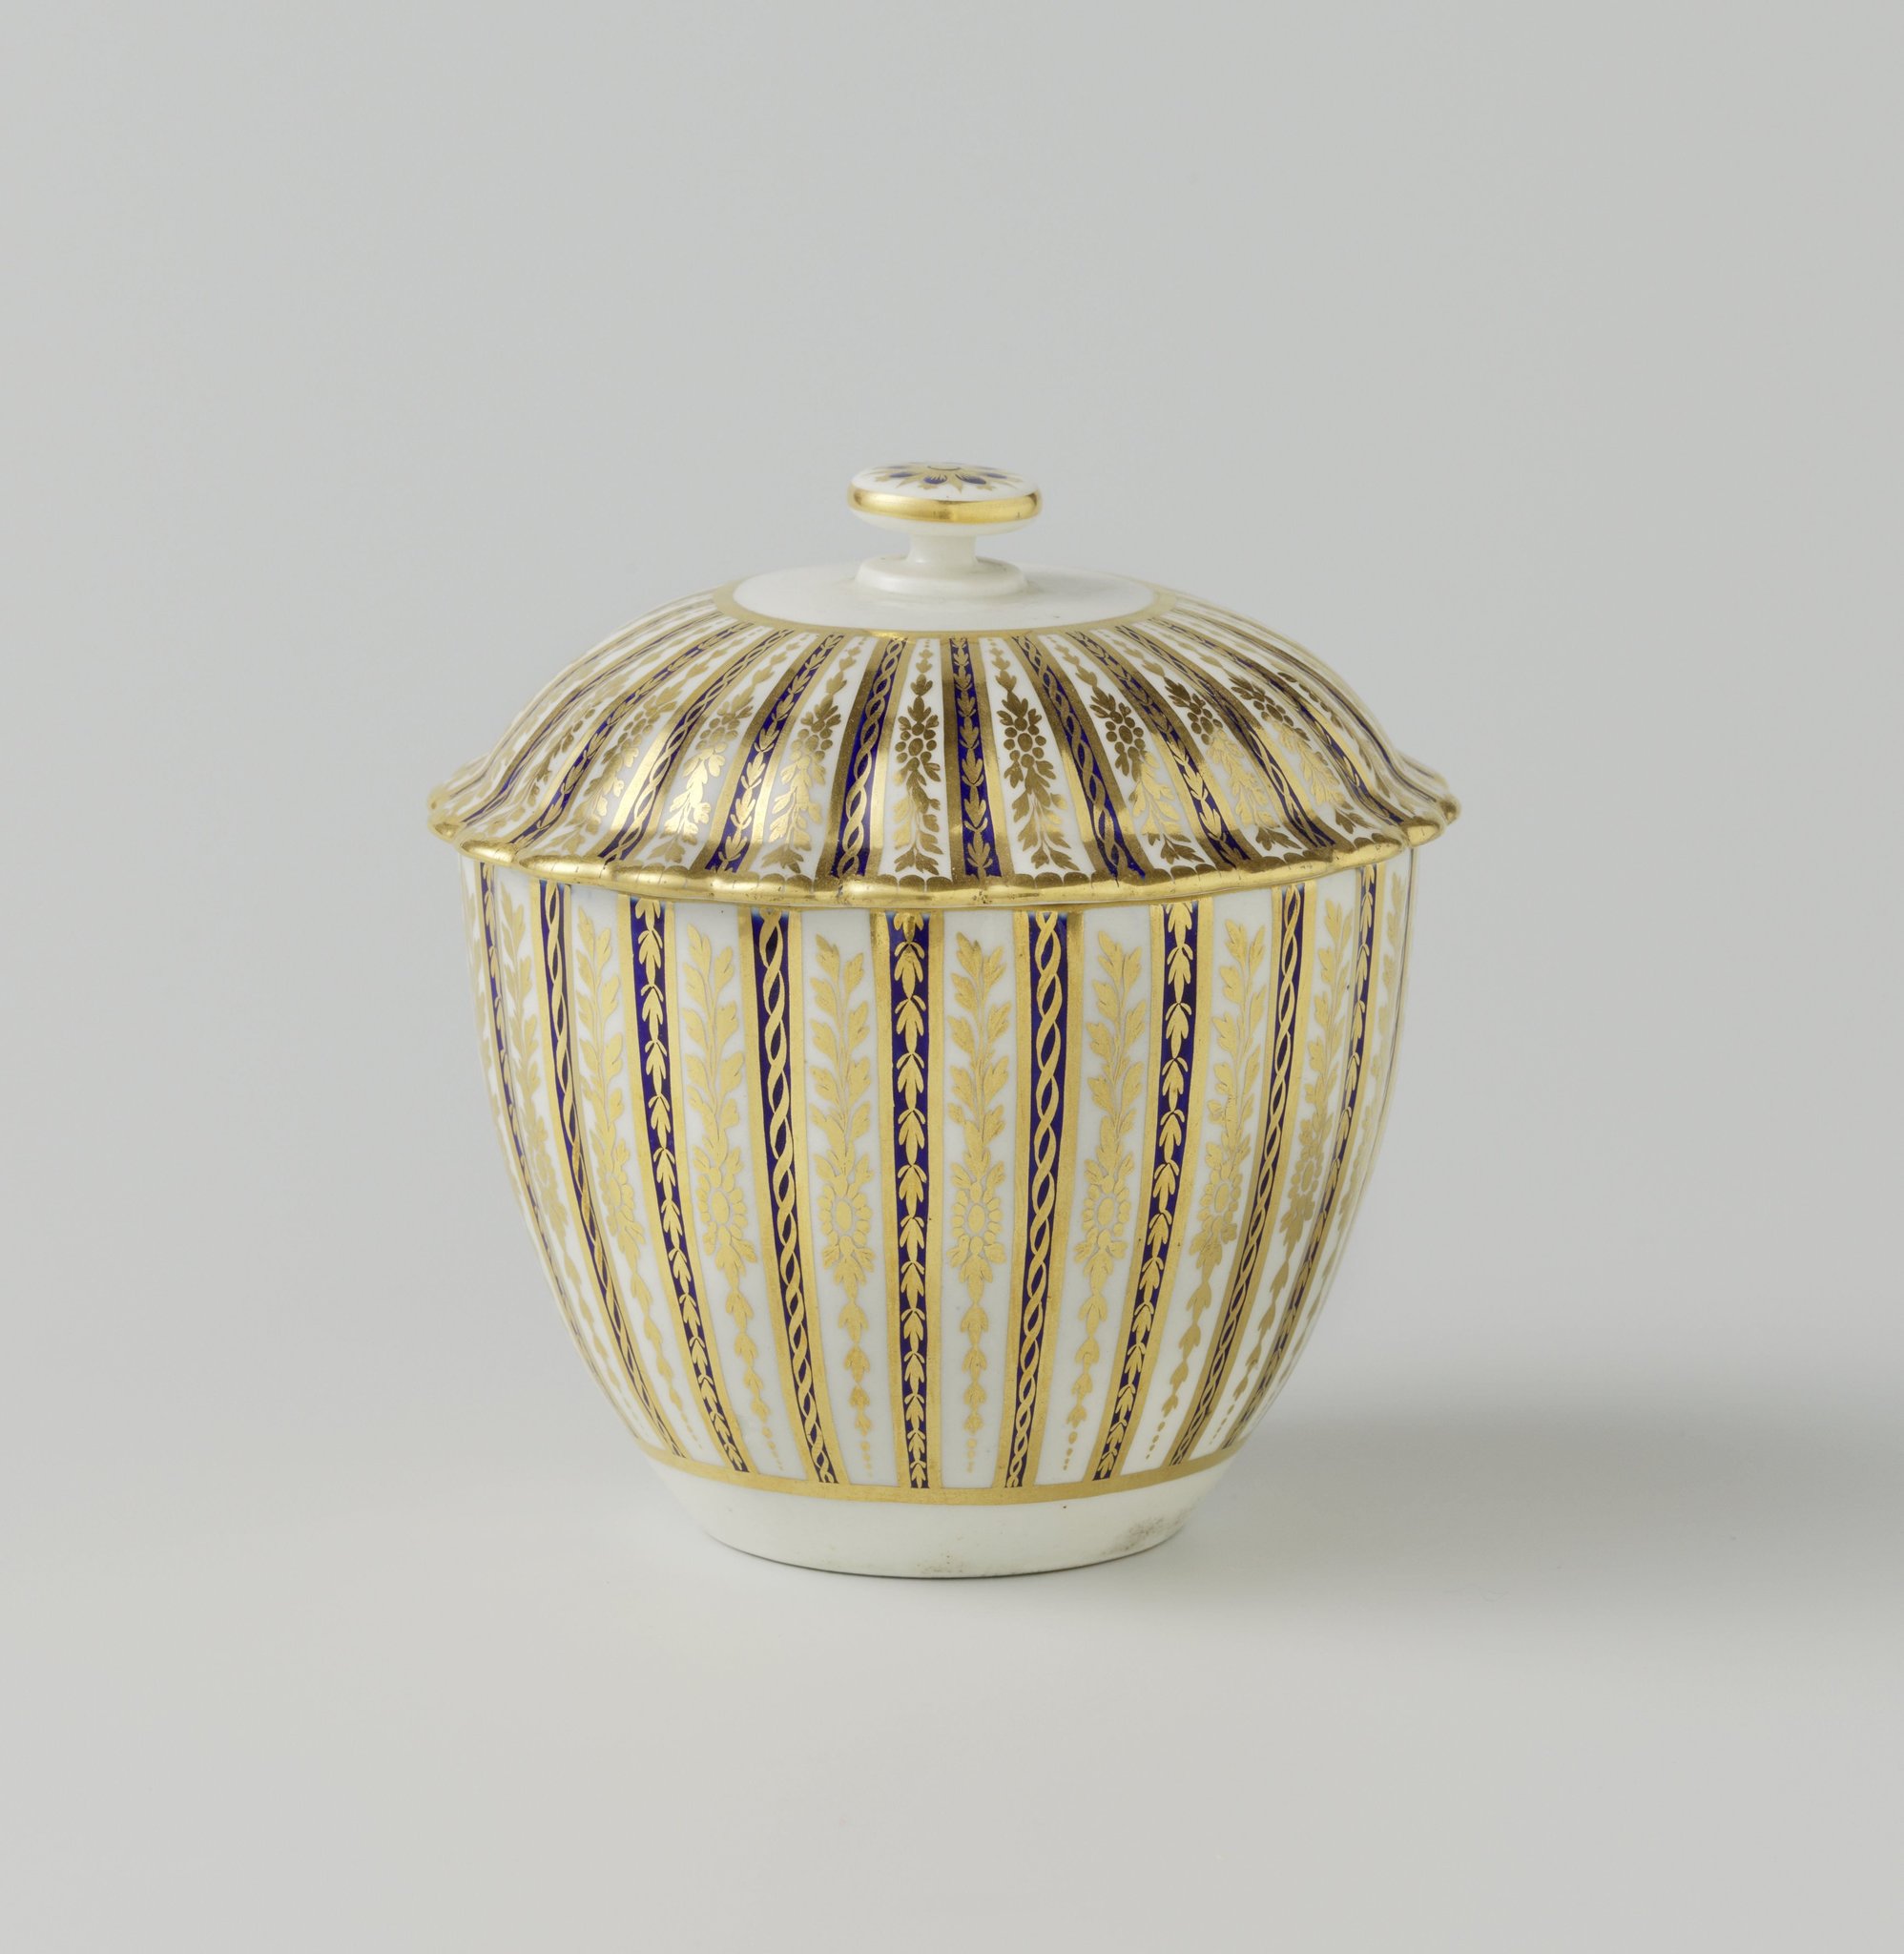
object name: sugar box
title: Suikerpot, de ribben afwisselend blauw en wit, gescheiden door gouden biezen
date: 1775-1800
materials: earthenware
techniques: vitrification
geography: worcester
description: Suikerpot met deksel. Geribd, de randen gekarteld. De ribben door verticale gouden biezen gescheiden. De holtes donkerblauw (Blue du Roi), de ribben wit, waarop een versiering van bladwerk en vlechtband. De randen verguld, verguldsel naar binnen gekarteld. Gemerkt in onderglazuurblauw.